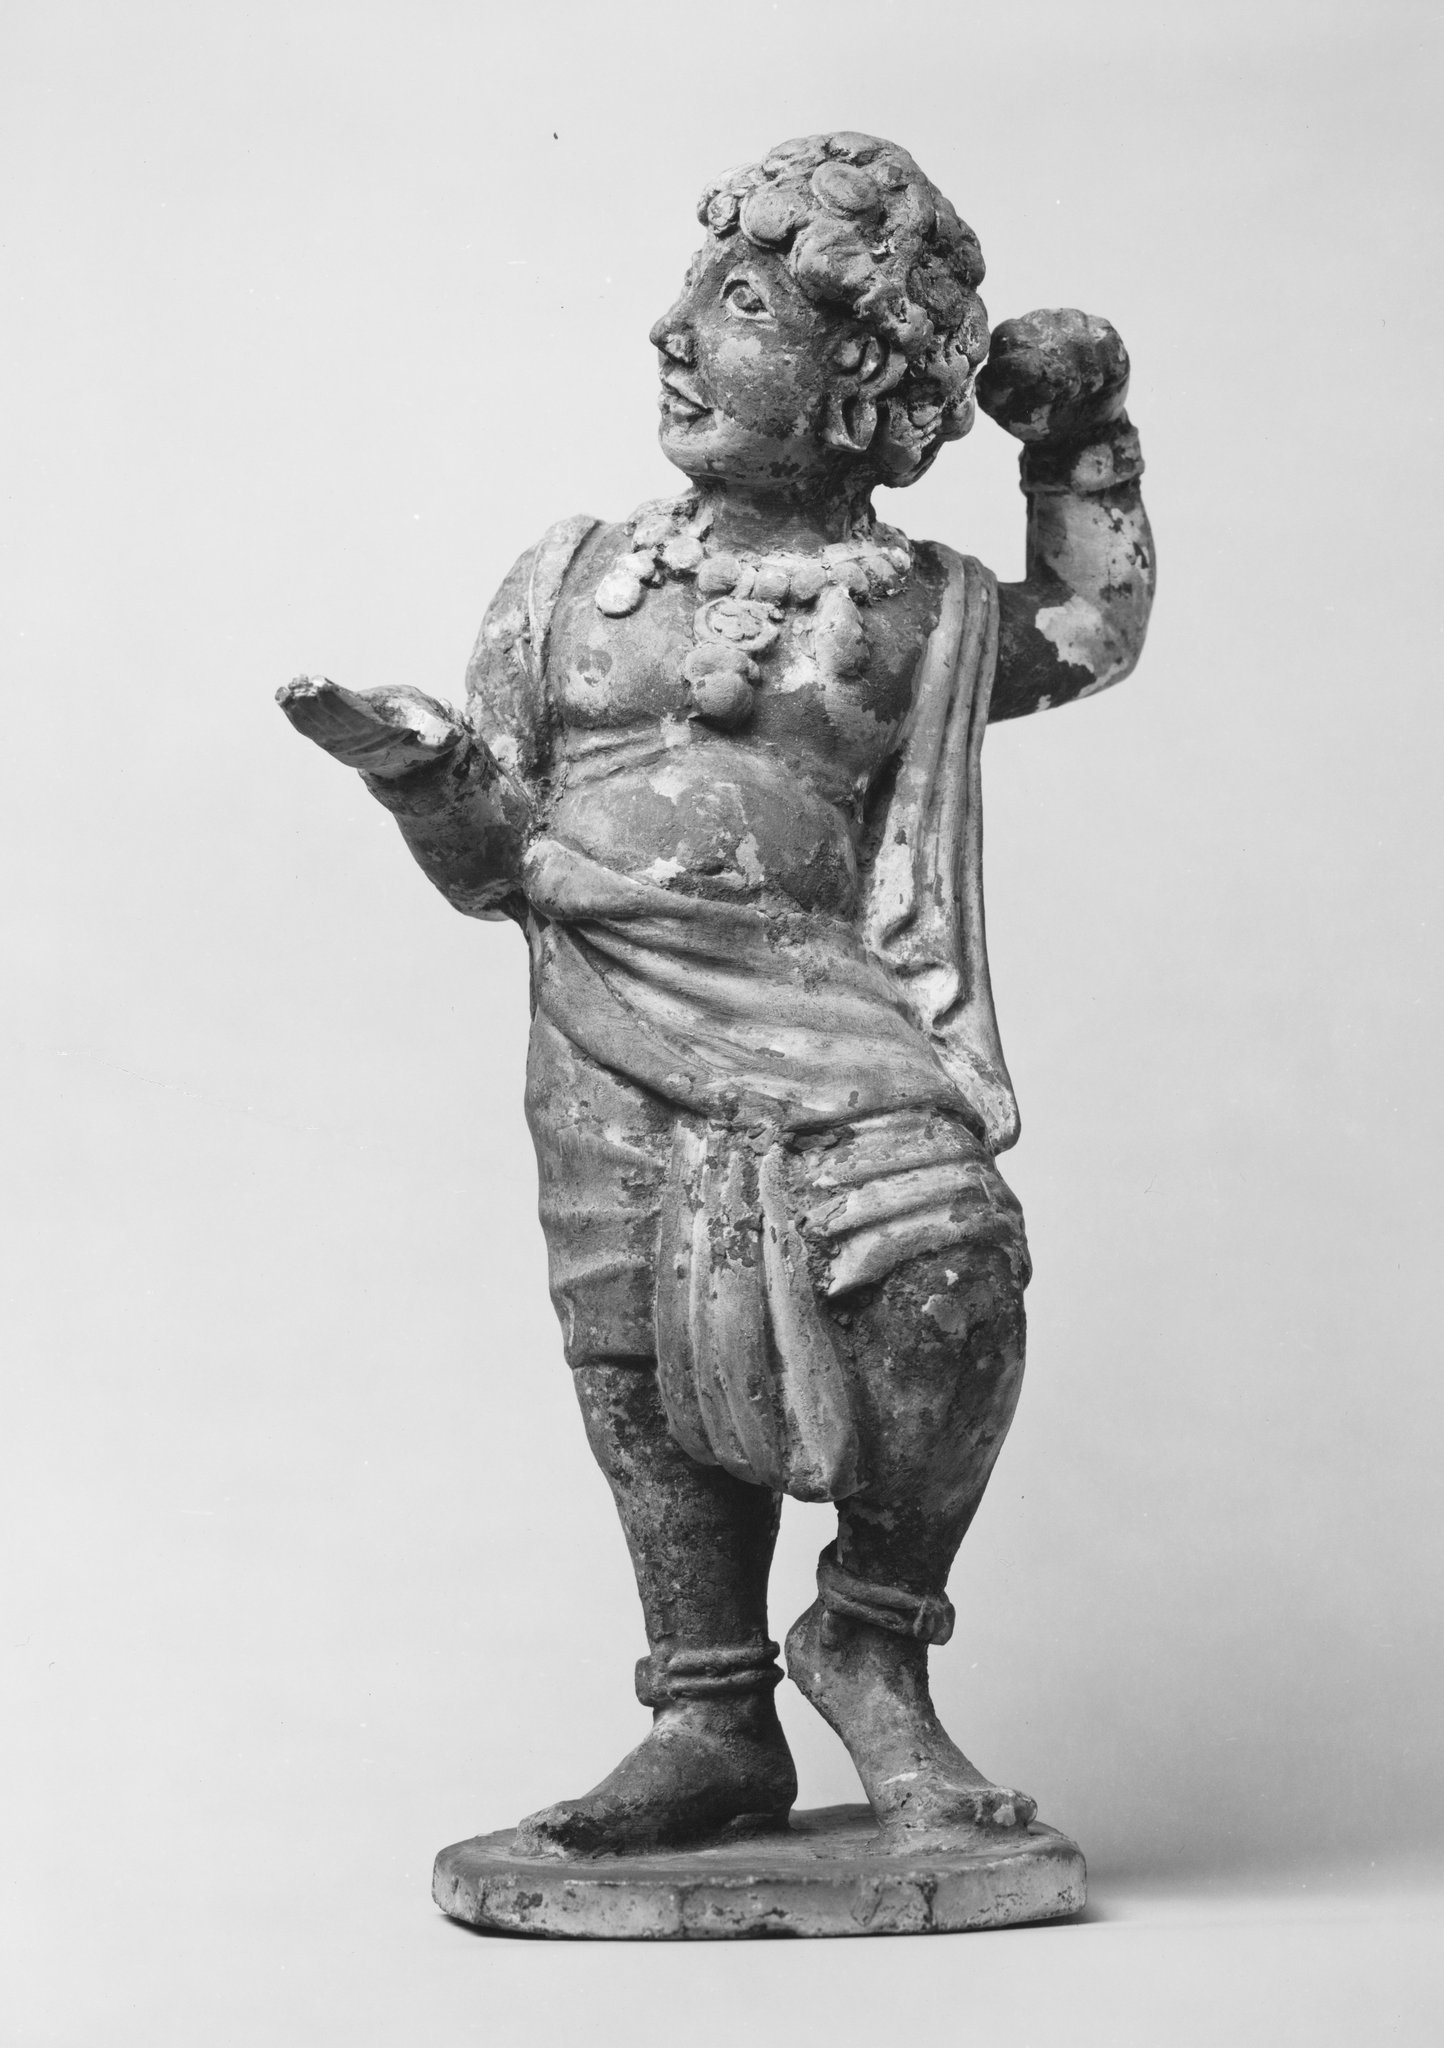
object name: figure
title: Foreign dancer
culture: chinese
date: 601-700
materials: earthenware, pigment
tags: dancers